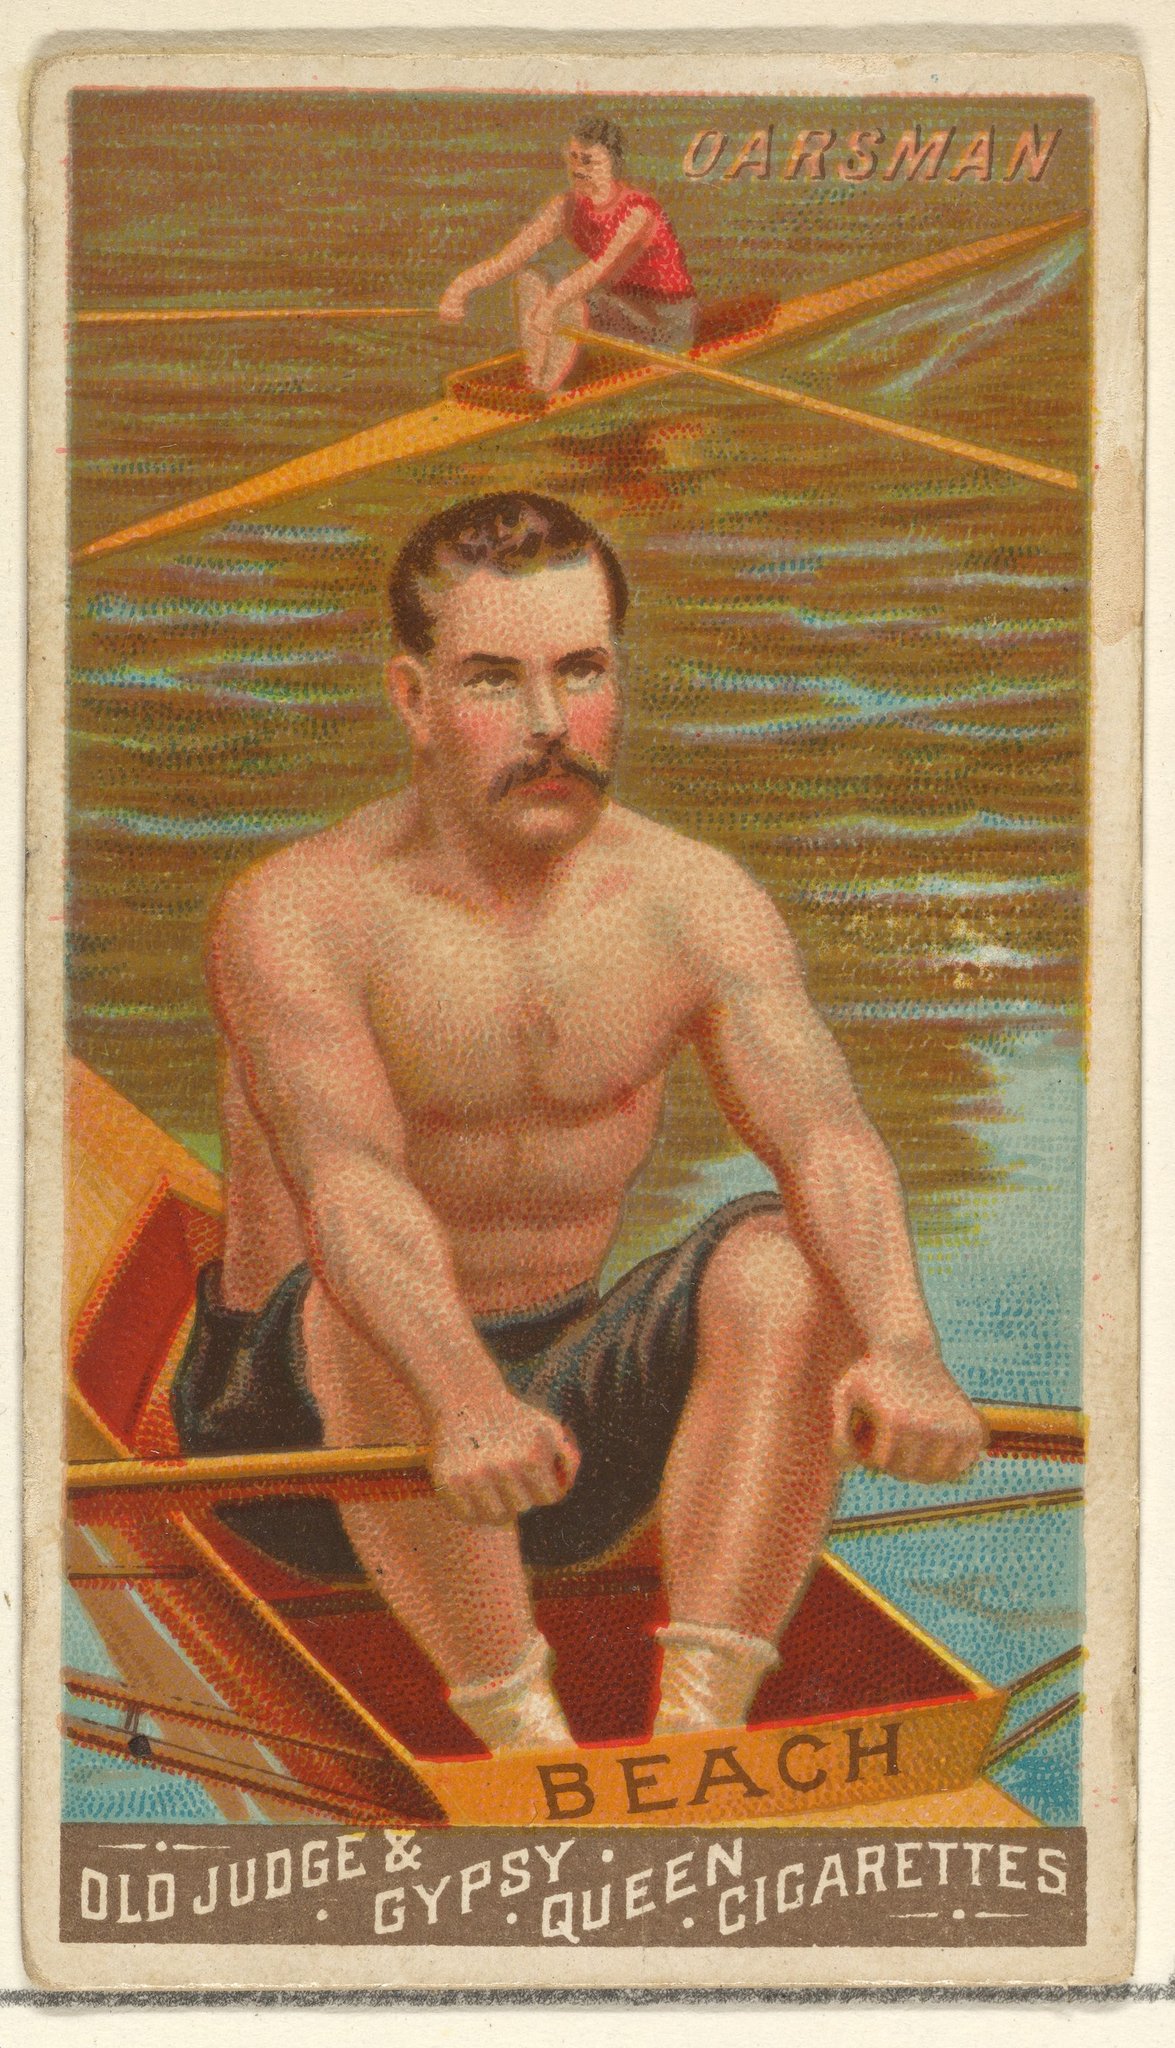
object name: print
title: Beach, Oarsman, from the Goodwin Champion series for Old Judge and Gypsy Queen Cigarettes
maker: goodwin & company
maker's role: publisher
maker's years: 1850-1950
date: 1888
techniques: color lithograph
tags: men,portraits,rowing,athletes,boats